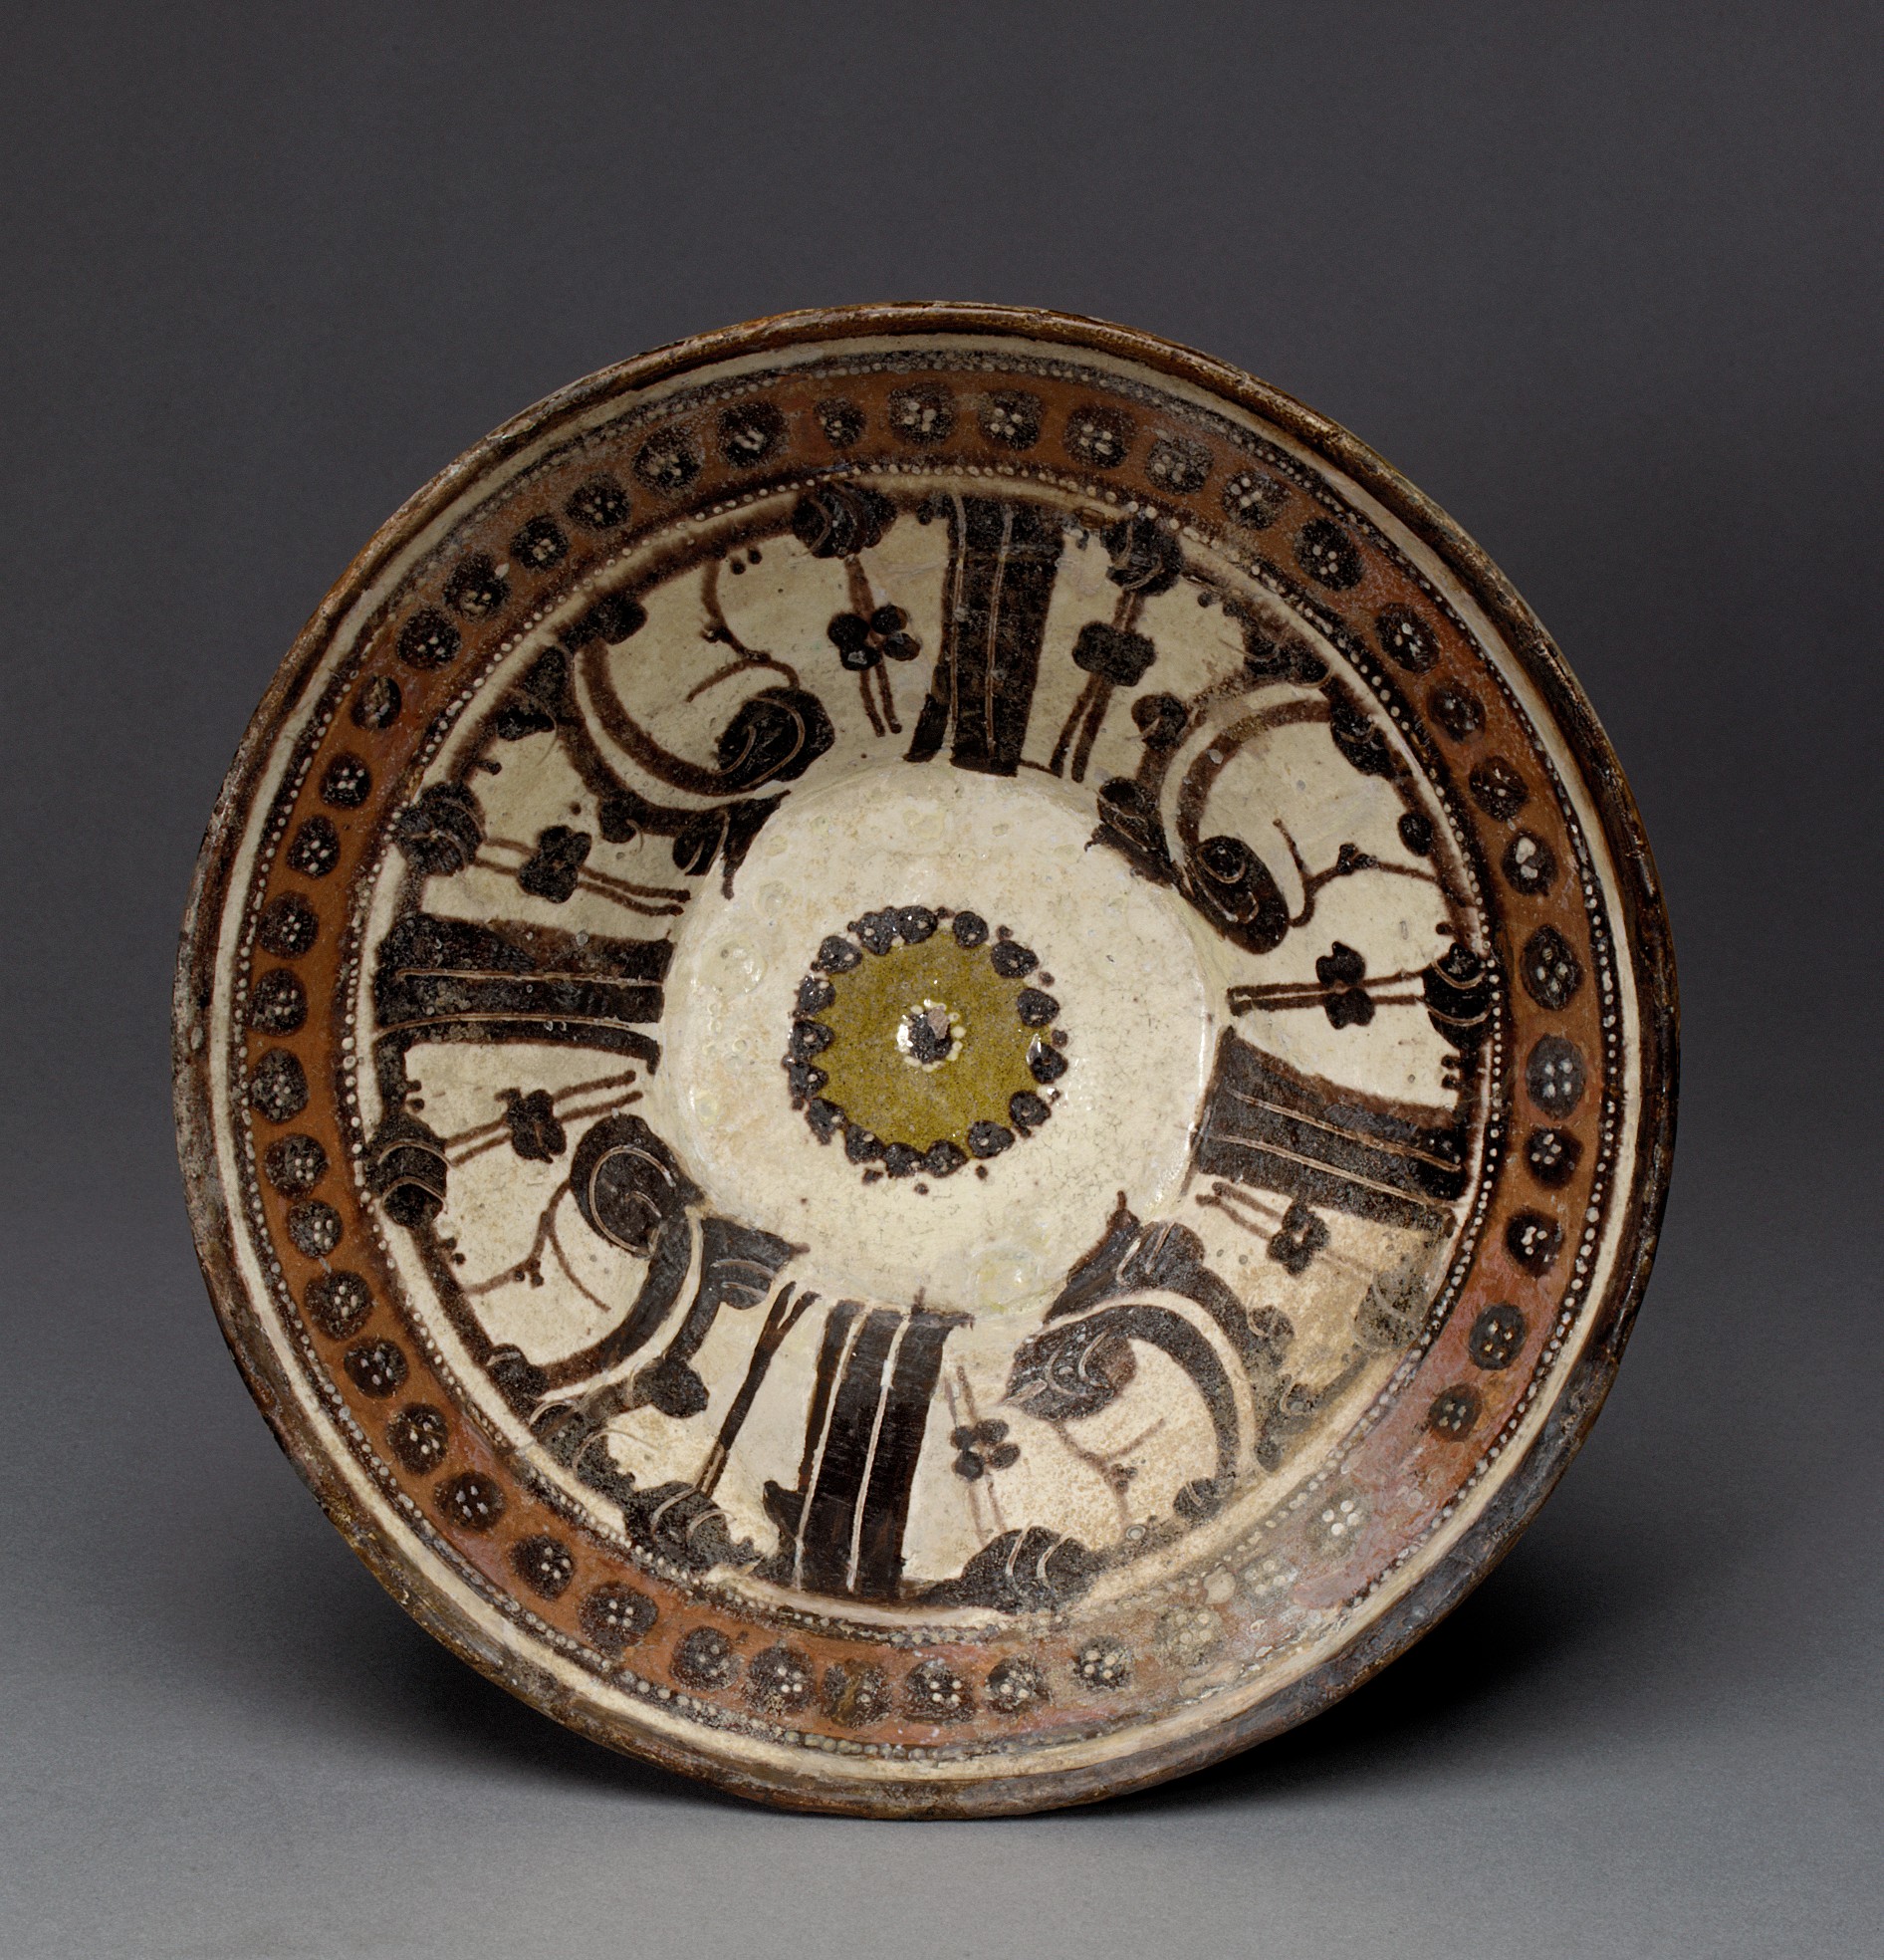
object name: bowl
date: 901-1000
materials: earthenware, glaze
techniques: polychrome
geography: iran